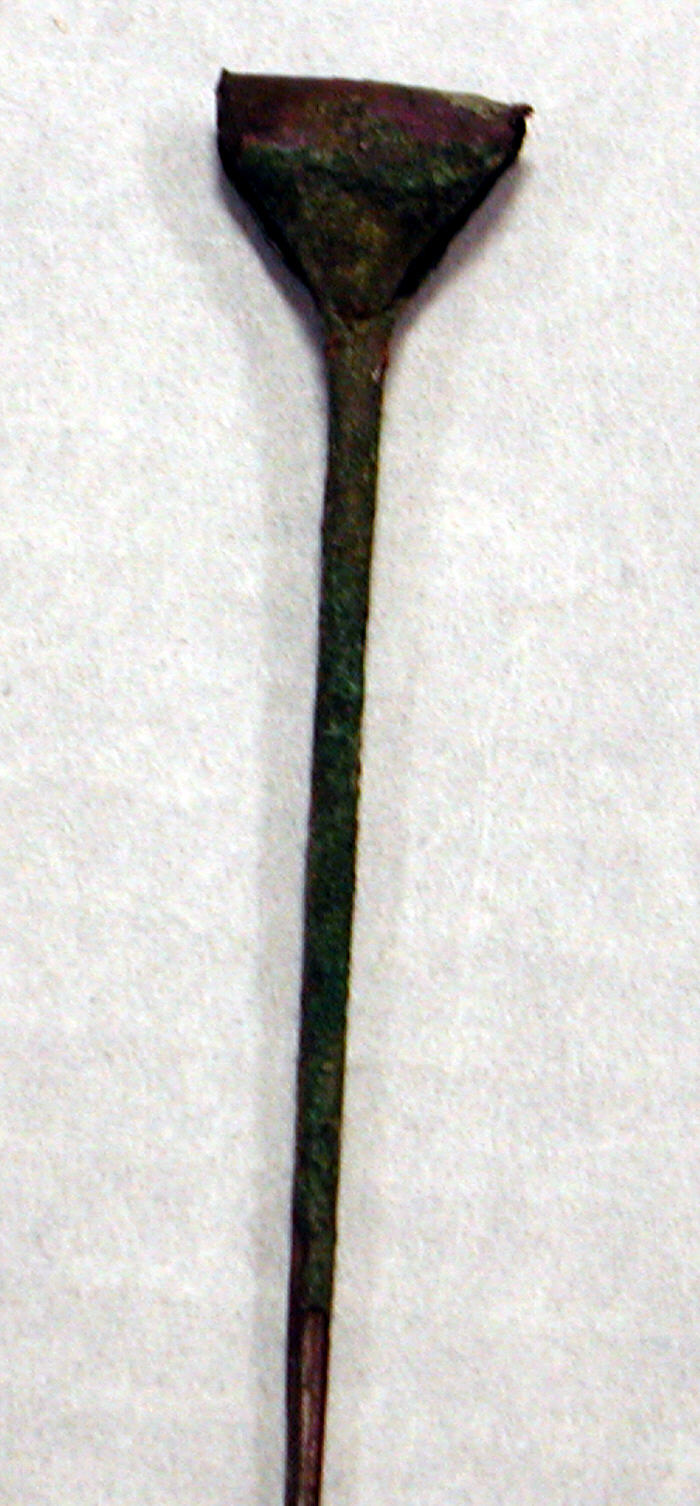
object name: rattle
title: Hammered Copper Rattle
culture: peruvian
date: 1-1566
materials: copper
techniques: hammering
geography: peru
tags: musical instruments